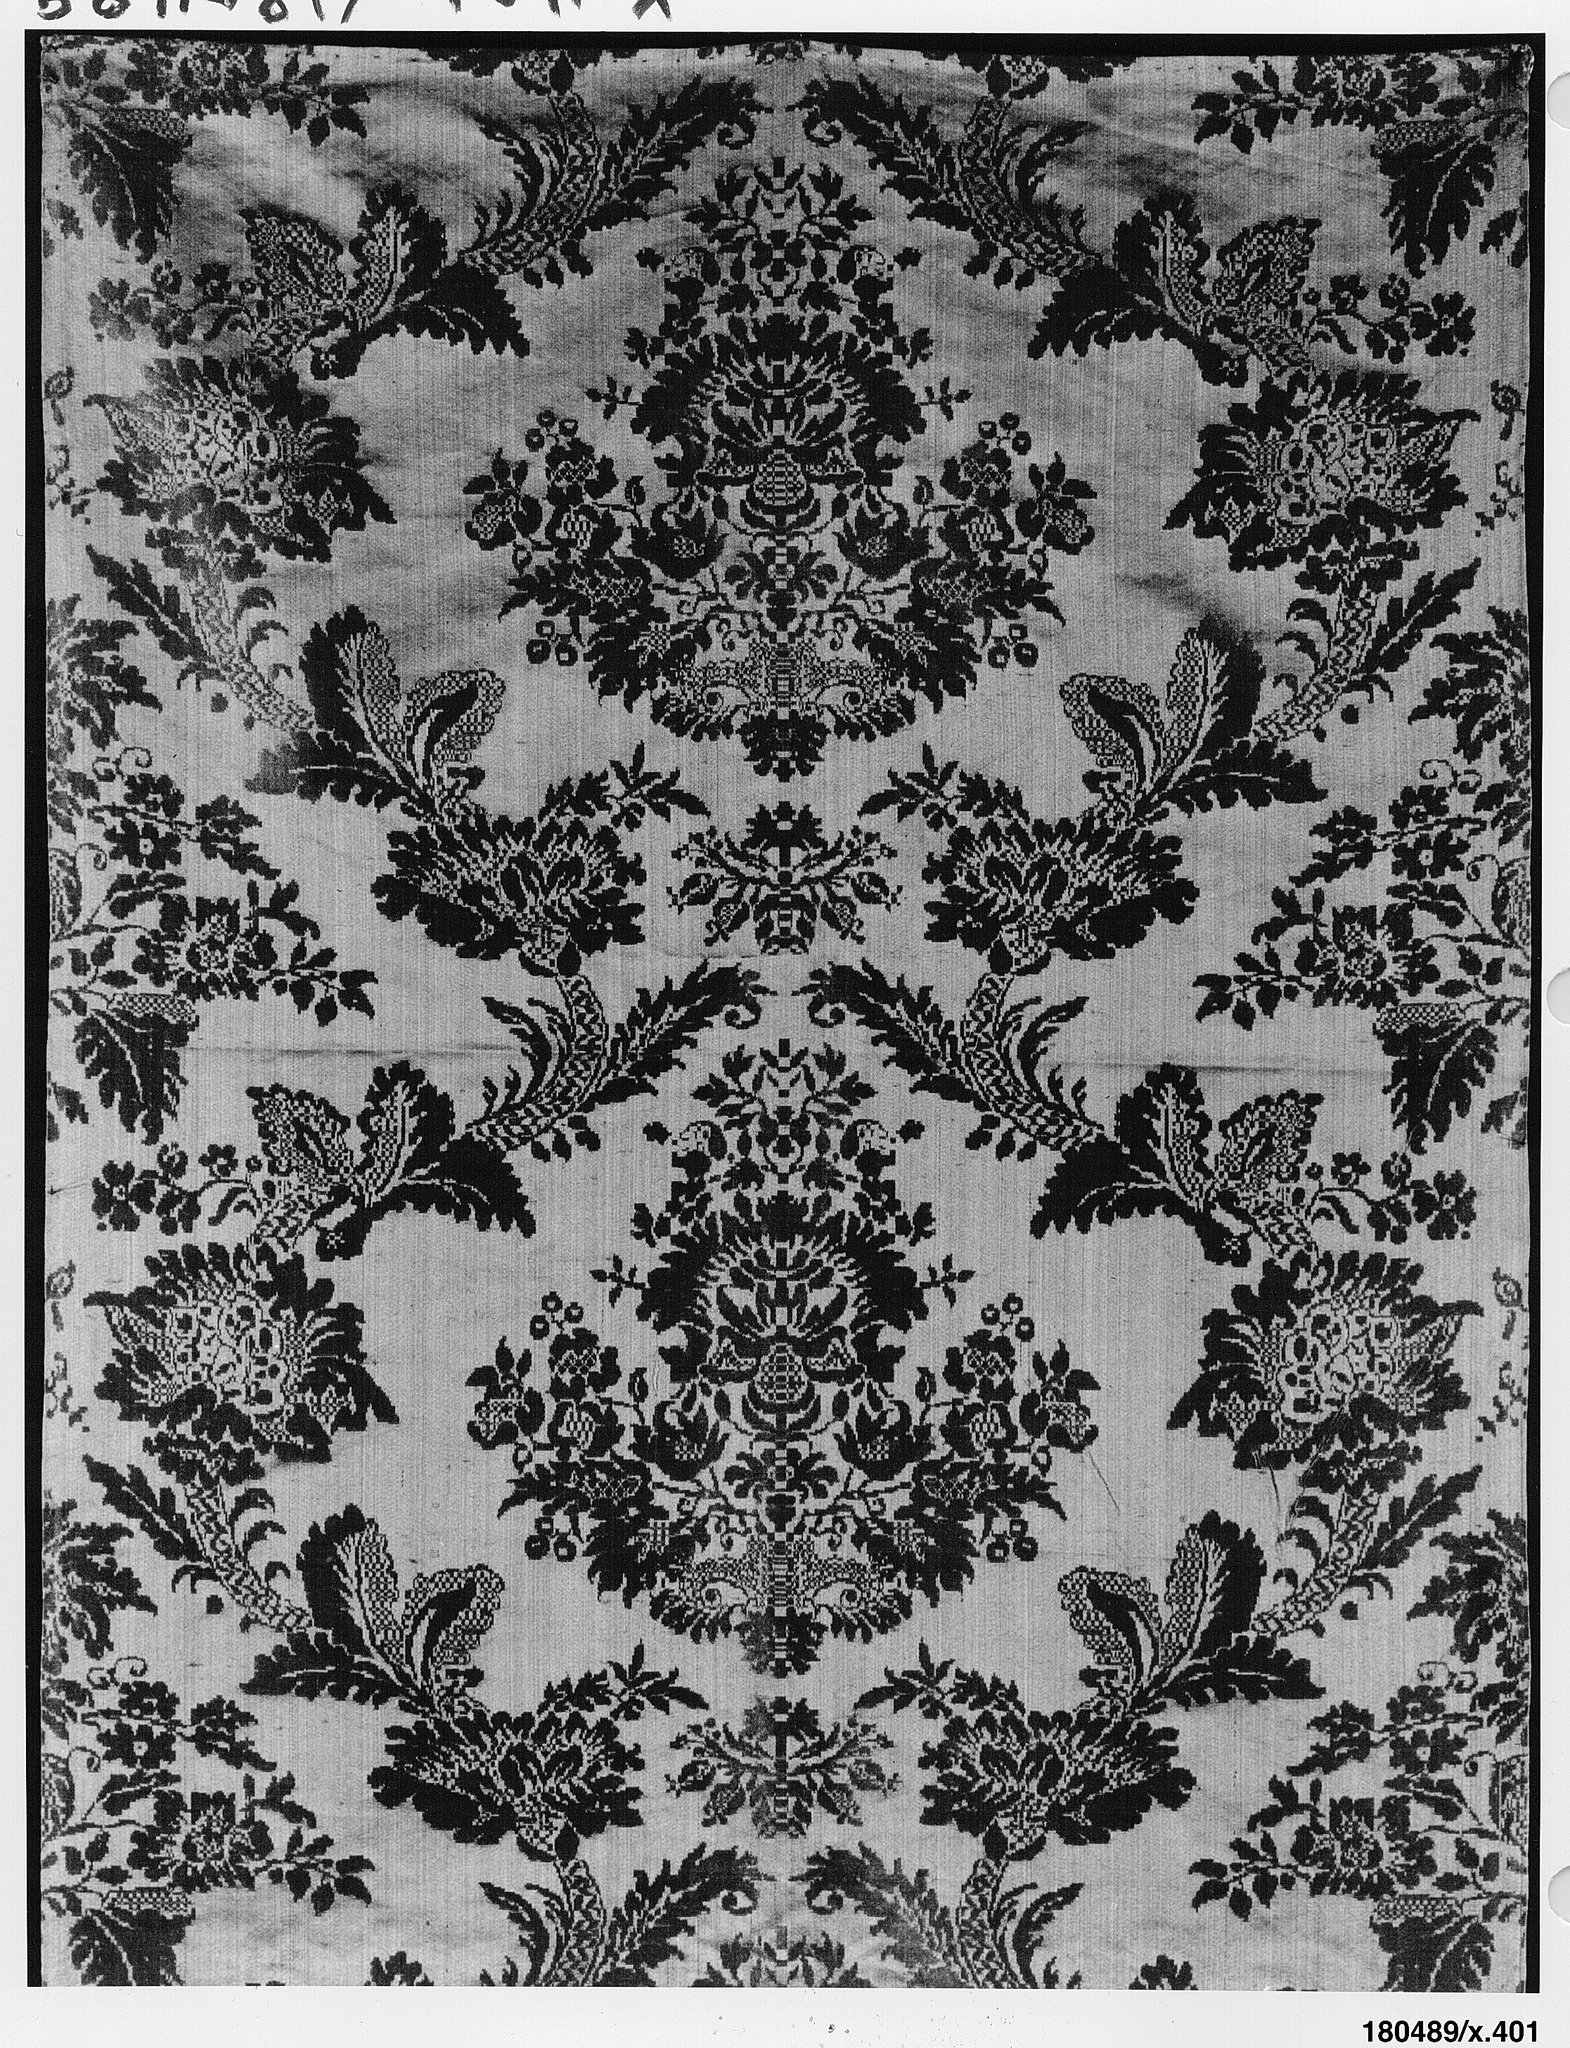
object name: piece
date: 1695-1705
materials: silk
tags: flowers